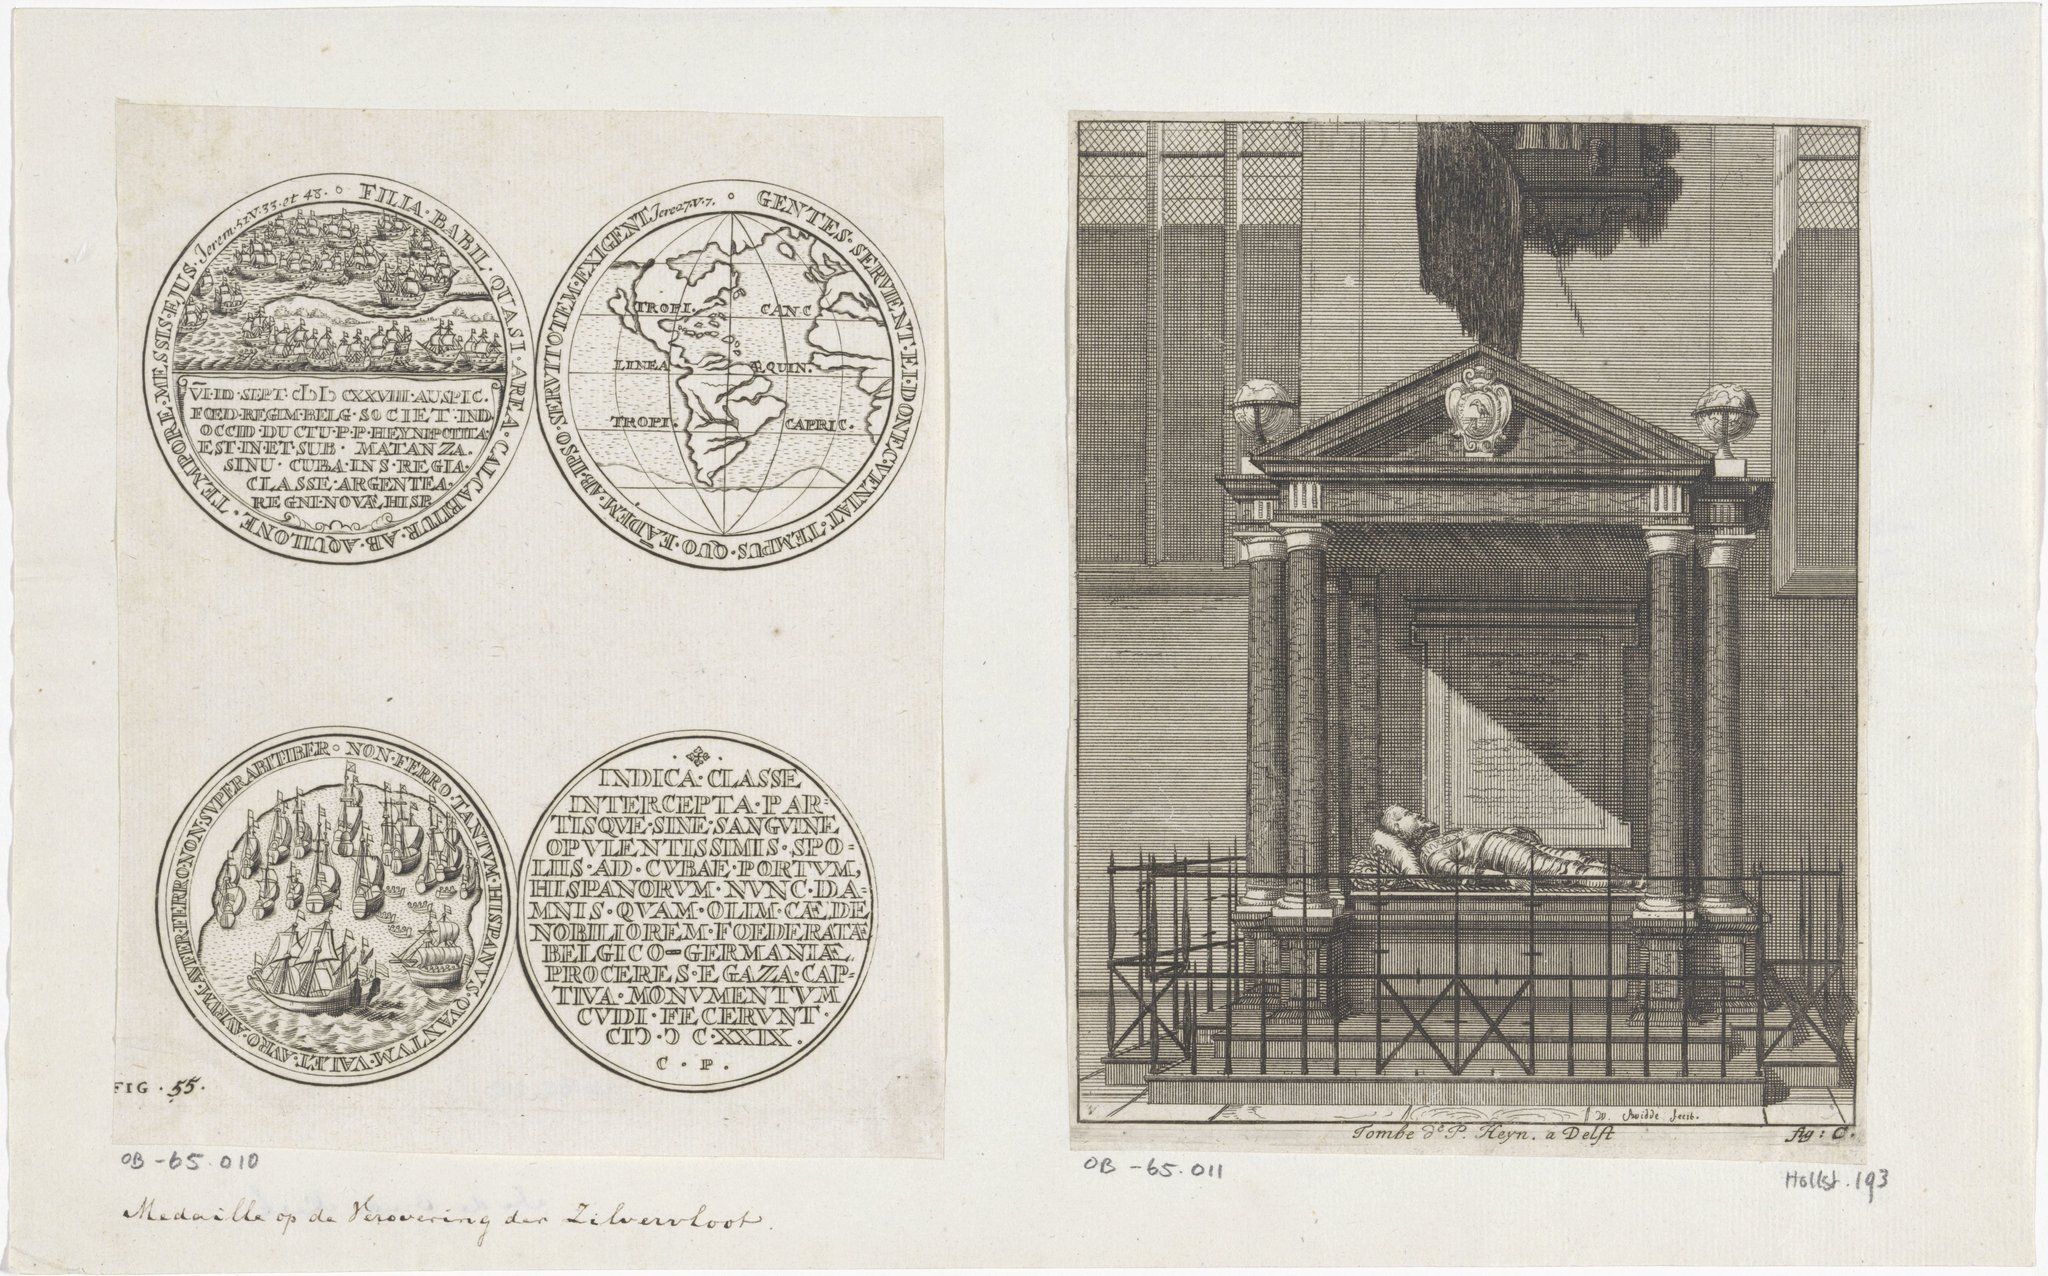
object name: book illustration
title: Twee penningen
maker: willem swidde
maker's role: print maker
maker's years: 1660-1697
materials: paper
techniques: engraving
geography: amsterdam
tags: coin, capture of the spanish treasure fleet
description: Medailles geslagen ter gelegenheid van de verovering van de Zilvervloot door Piet Heyn, voor- en achterzijde. In de linkerbenedenhoek gesigneerd "Fig. 55".